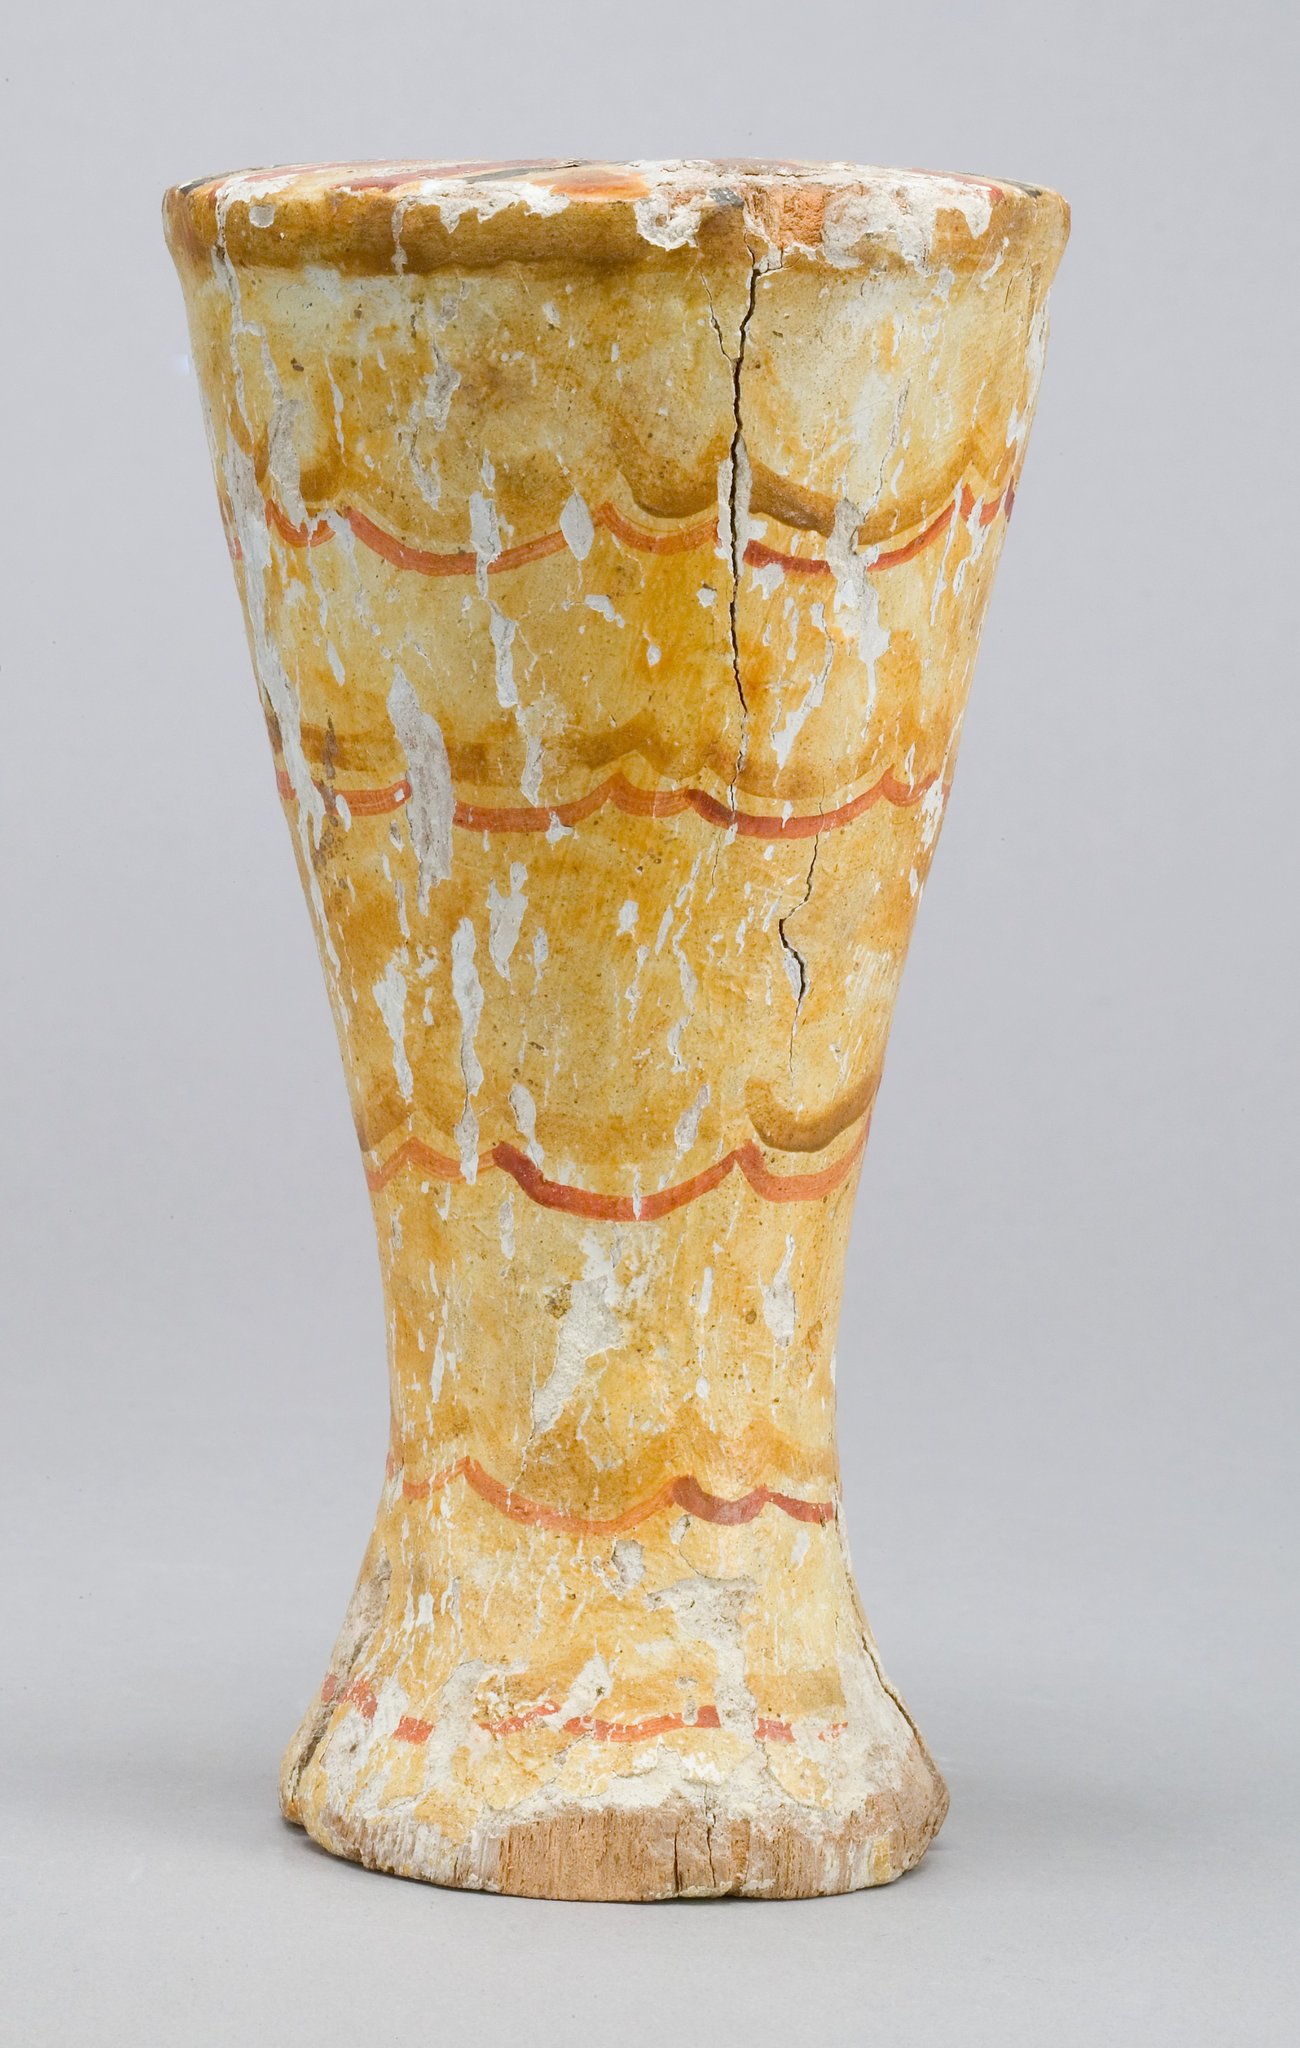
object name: model vase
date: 1479-1390 BCE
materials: paint, wood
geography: egypt